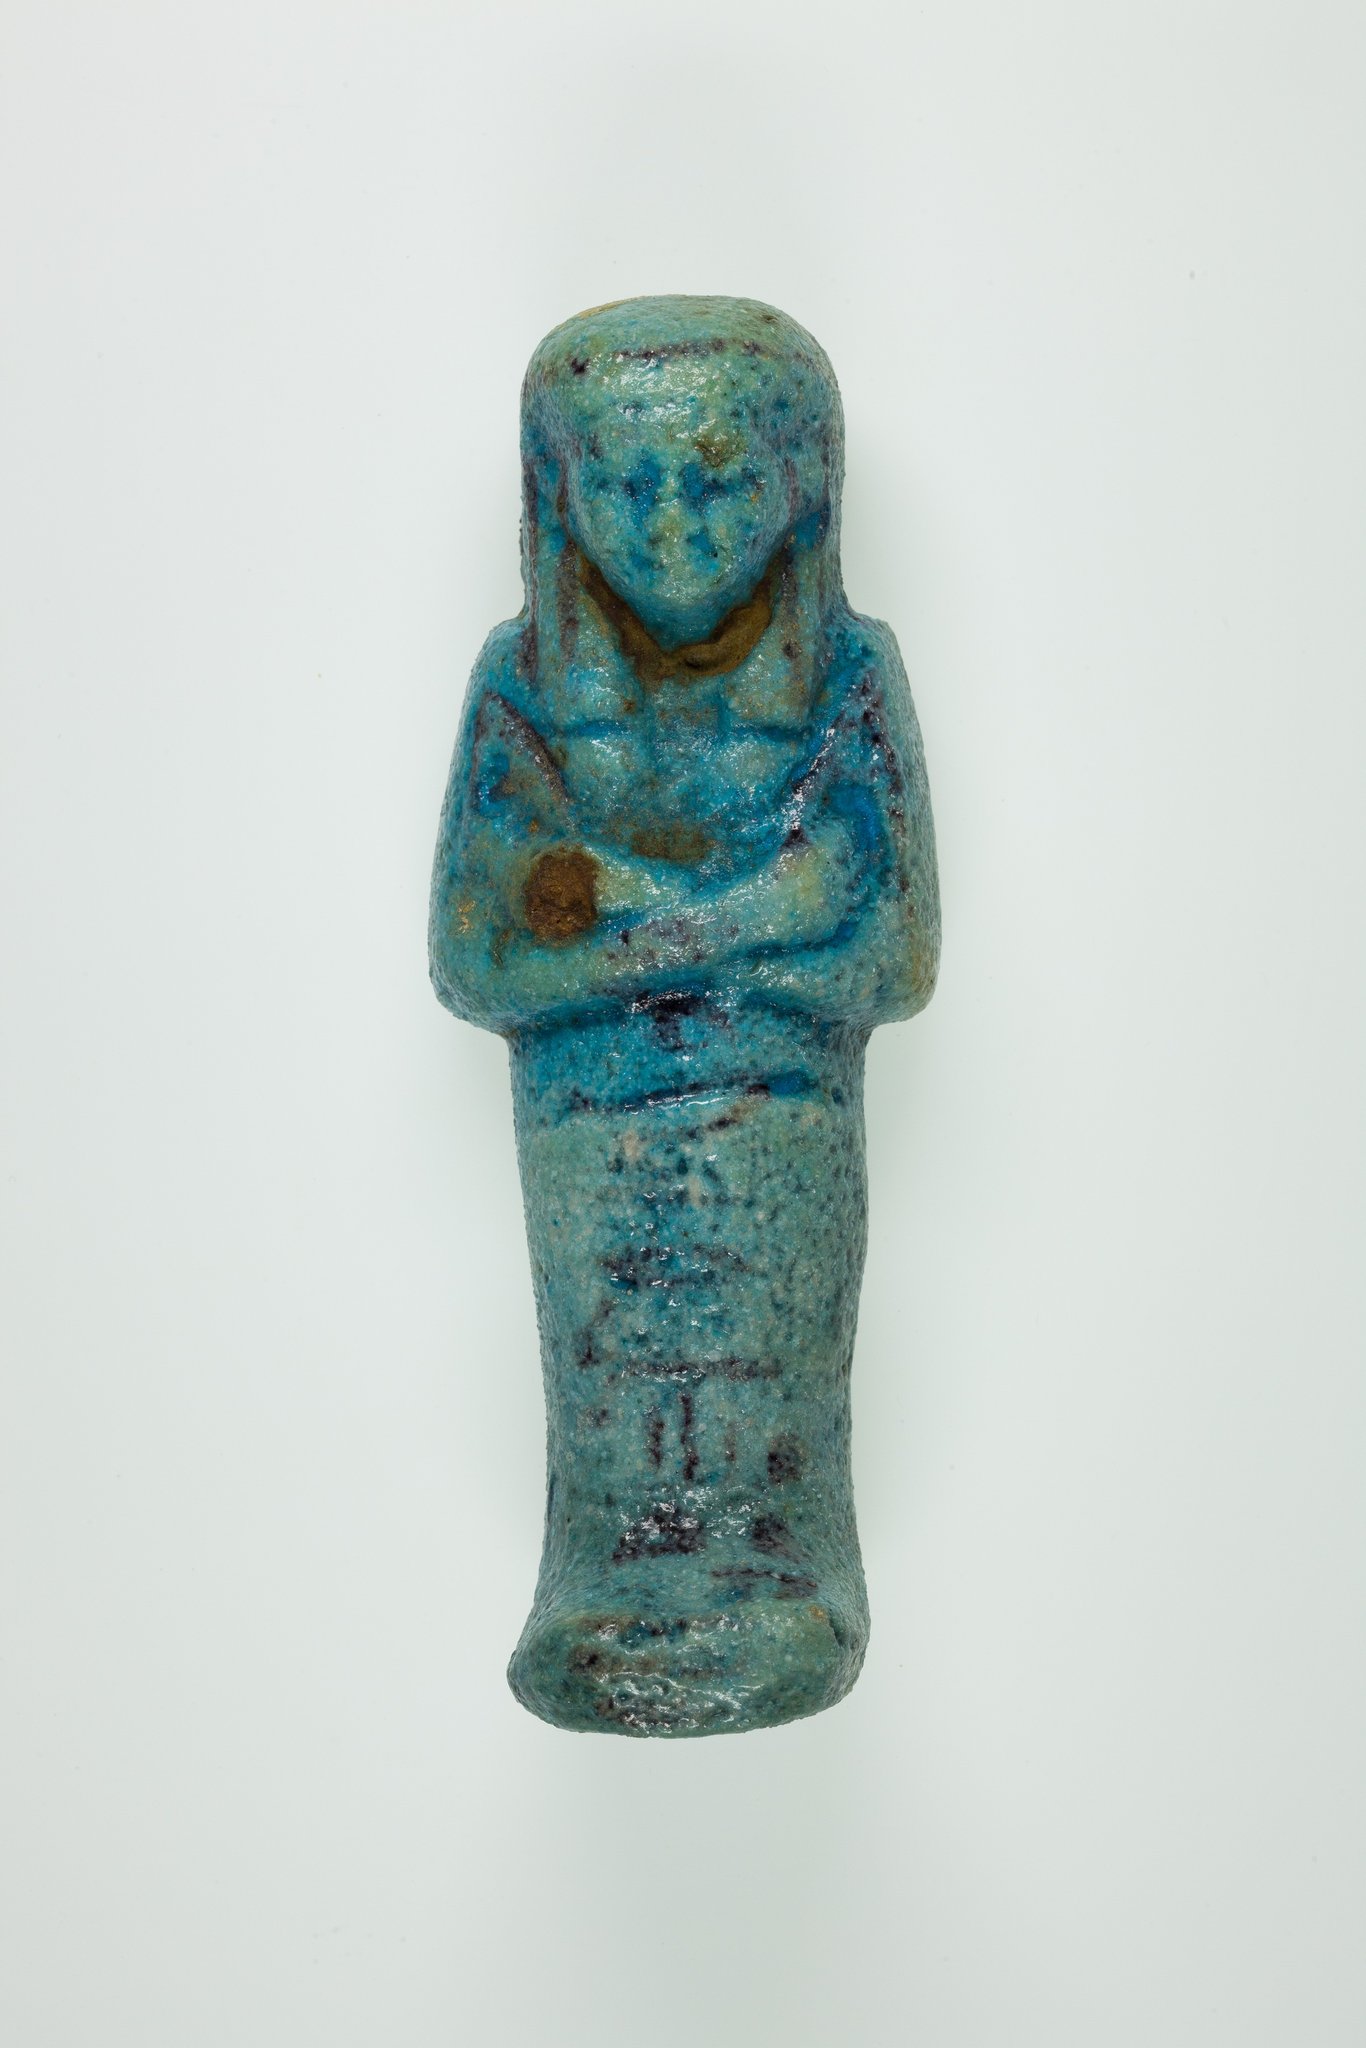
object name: worker shabti, henettawy c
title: Worker Shabti of Henettawy (C), Daughter of Isetemkheb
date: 990-970 BCE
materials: faience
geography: egypt